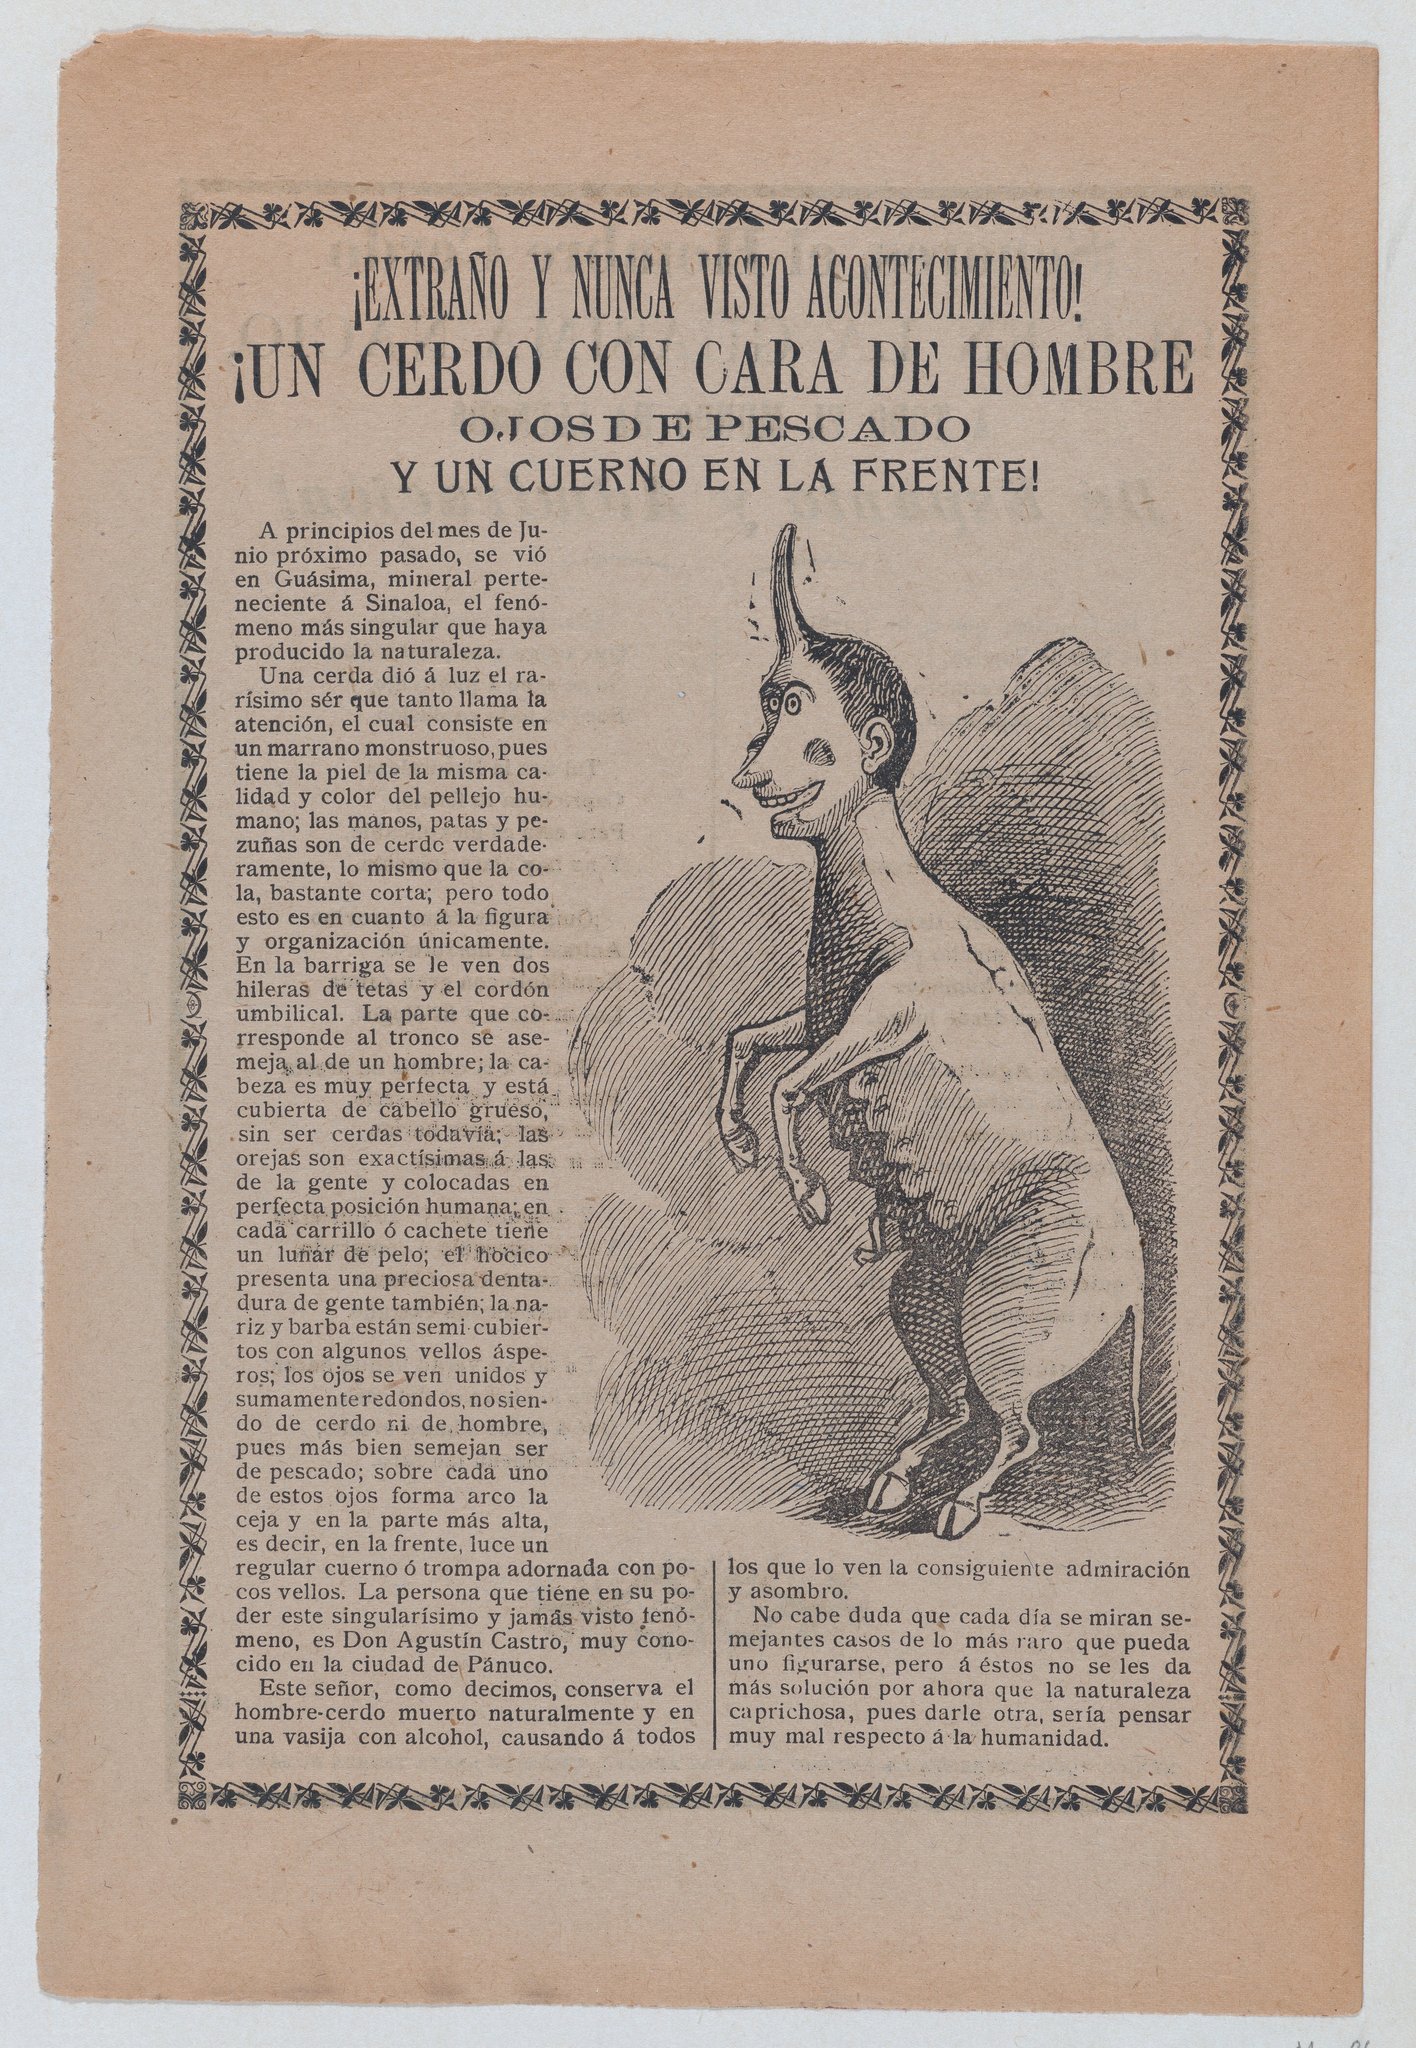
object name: print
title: Broadsheet relating to freaks of nature, at right a creature that is half human and half pig with a single horn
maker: josé guadalupe posada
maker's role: artist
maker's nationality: mexican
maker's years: 1852-1913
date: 1899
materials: paper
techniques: letterpress, lithography